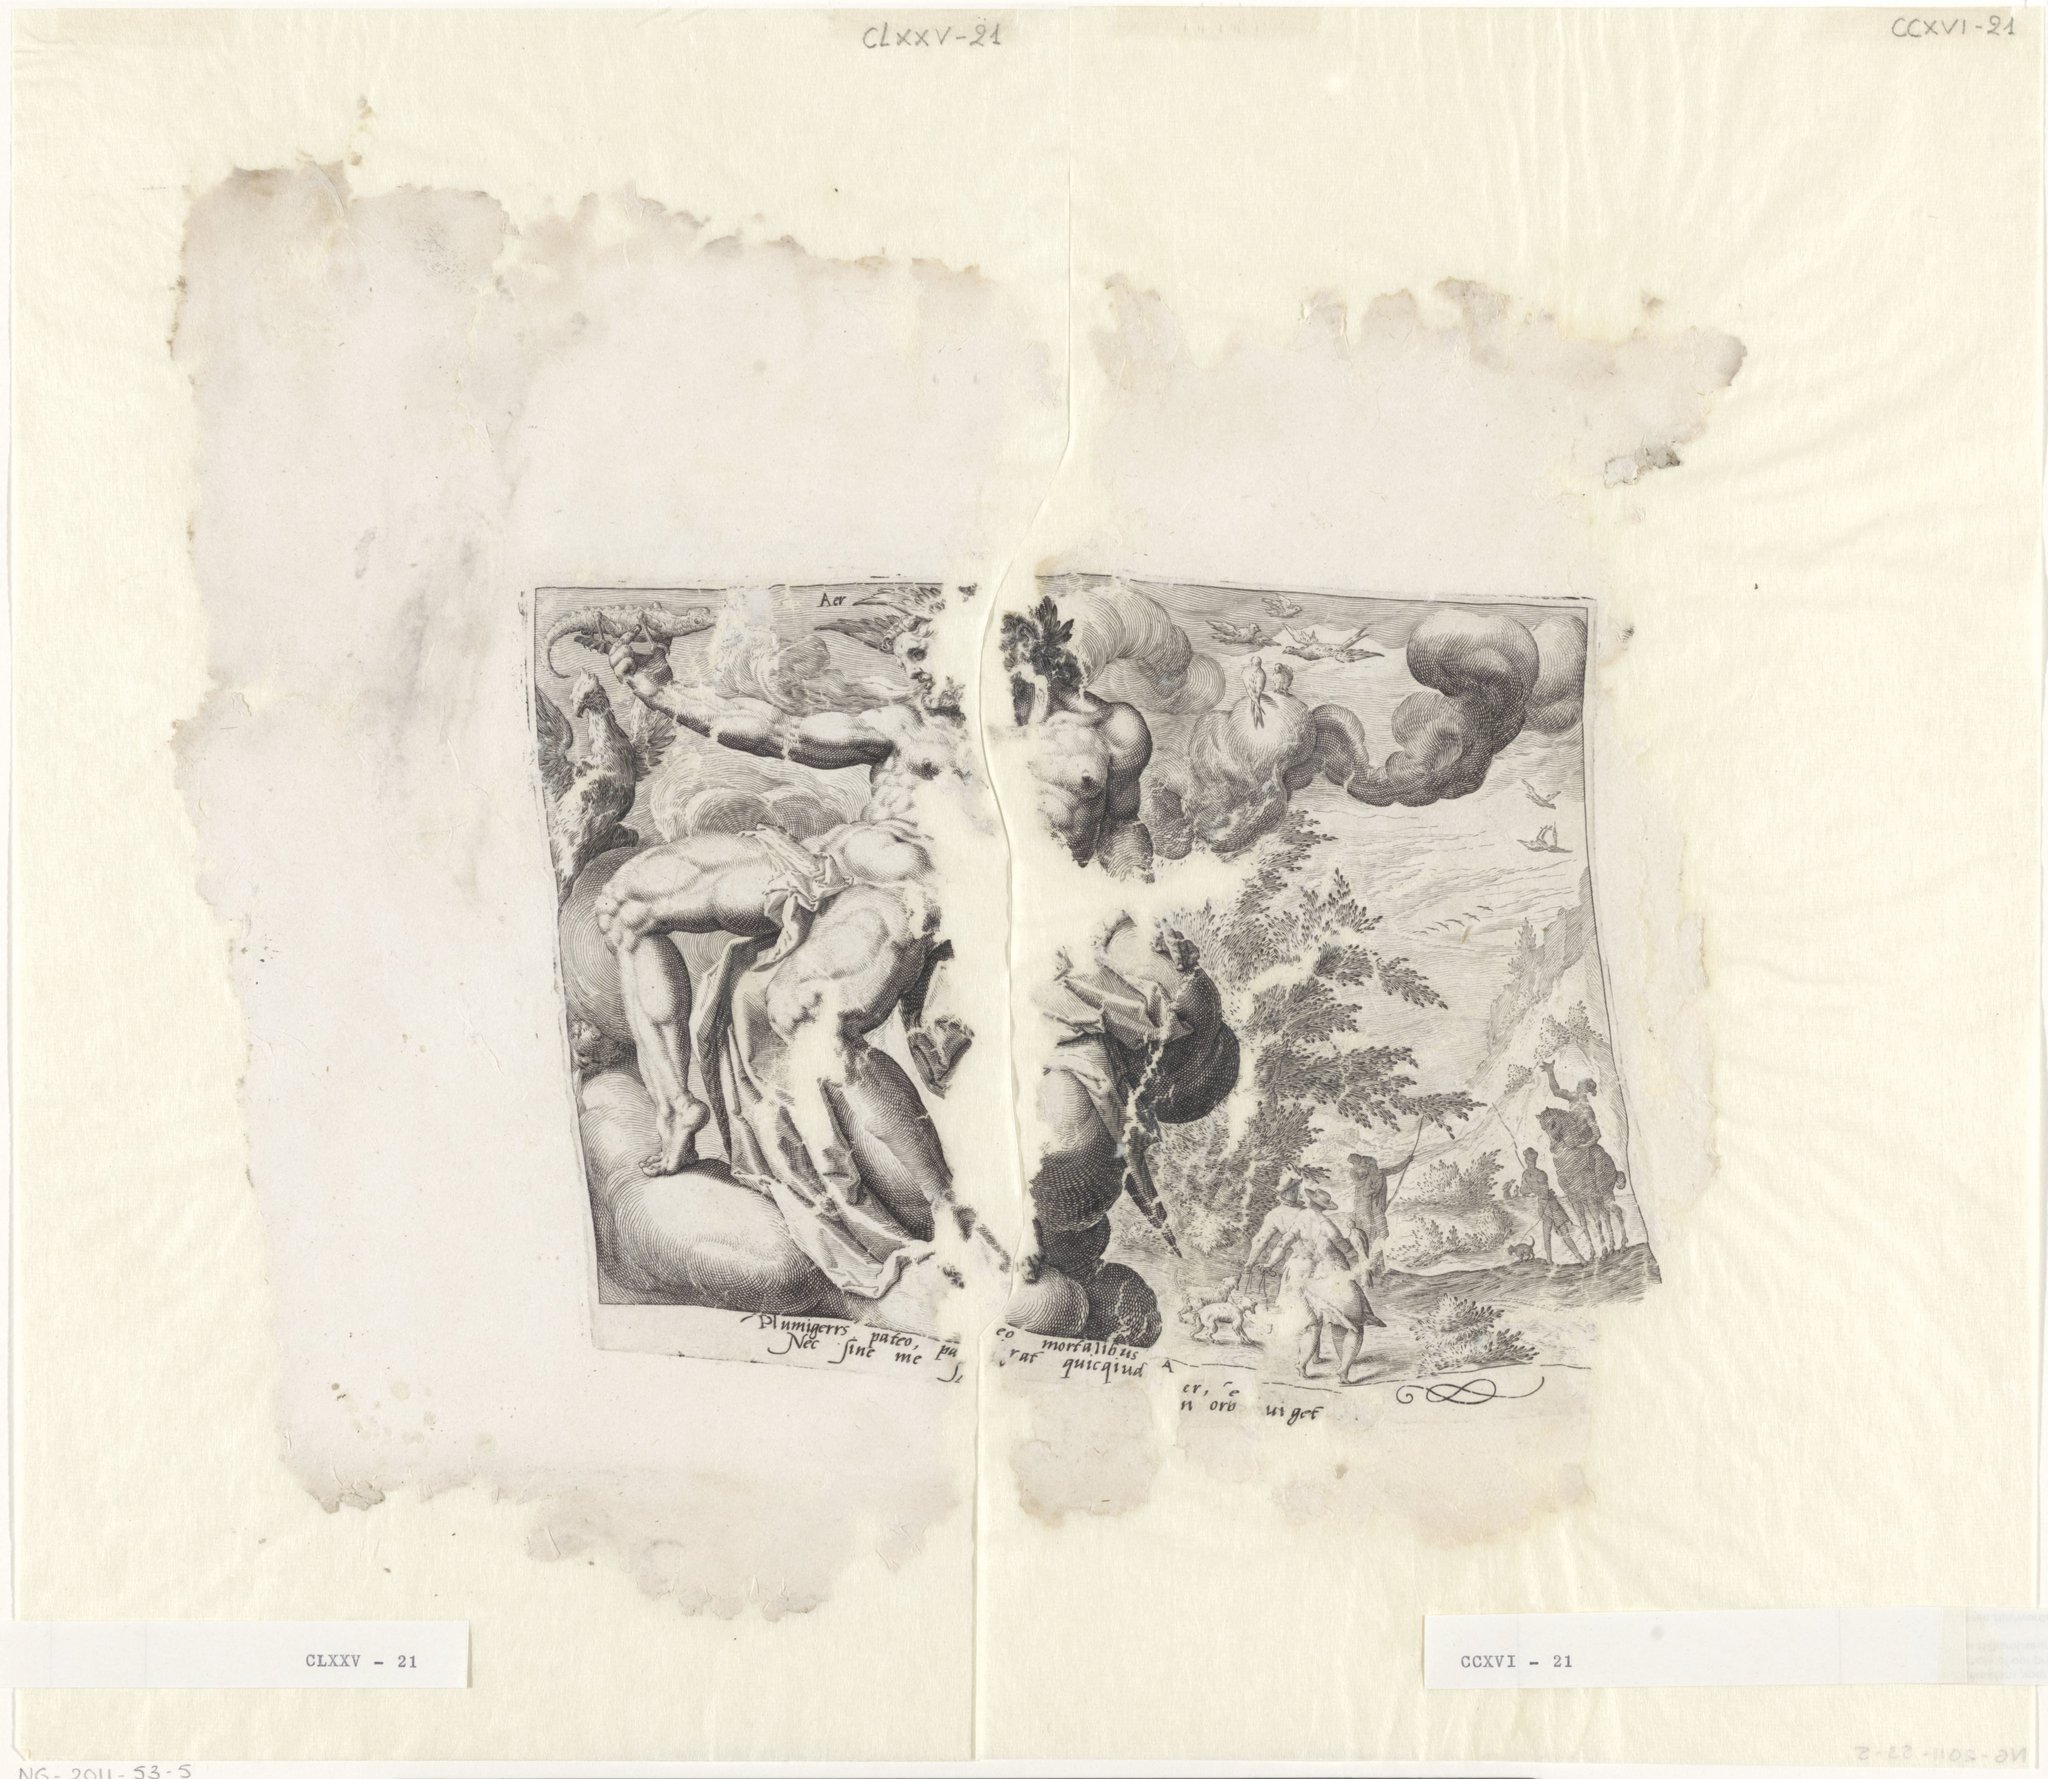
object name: print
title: Lucht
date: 1580-1596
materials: paper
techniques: engraving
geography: amsterdam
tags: air (one of the four elements)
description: De prenten in de Nova Zembla collectie zijn tijdens een expeditie van Willem Barendsz en Jacob van Heemskerk in 1596-1597 noodgedwongen in het winterkamp, het ‘Behouden Huis’, op het eiland achtergelaten. De prenten waren in één of meerdere stapels als handelswaar meegenomen vanuit Amsterdam. Bijna drie eeuwen later, in 1871, keerde de Noor Elling Carlsen terug naar Nova Zembla en vond daar de restanten van het ‘Behouden Huis, inclusief een groot deel van de inventaris. Een deel van de prenten, in de vorm van aaneengekoekte kluiten, werd toen ook teruggevonden. De papierkluiten waren soms op meerdere plekken gebroken. Tussen 1975-1979 zijn de prenten van elkaar gescheiden. Dit leverde in totaal ca. 1000 fragmenten van ca. 400 afdrukken van ca. 150 verschillende prenten op. Voor zover mogelijk zijn de fragmenten samengevoegd en zijn de prenten gereconstrueerd.